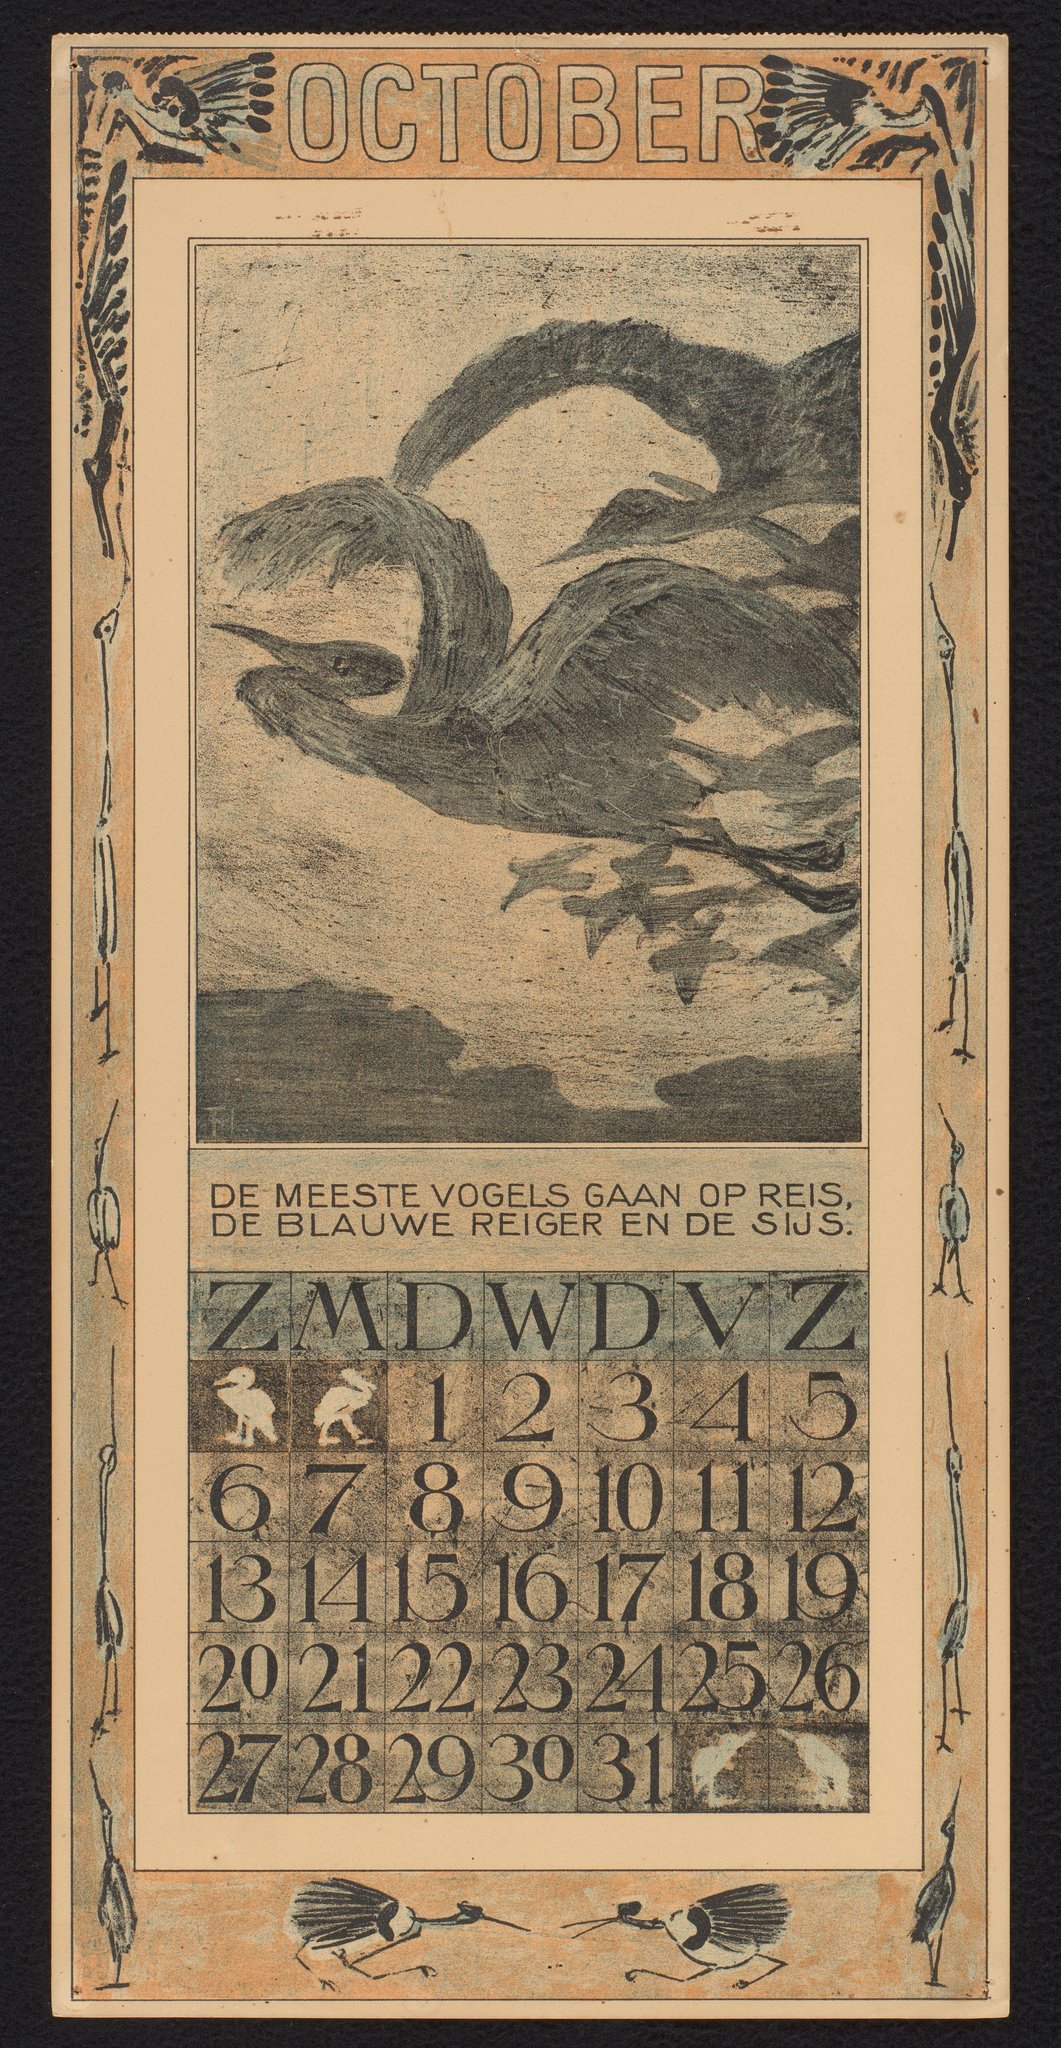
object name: calendar leaf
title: Kalenderblad voor oktober 1907 met reigers op trek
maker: theo van hoytema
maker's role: draughtsman, painter, print maker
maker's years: 1863-1917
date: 1906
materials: paper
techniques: lithograph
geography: amsterdam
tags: calendar, almanac, shore-birds and wading-birds: heron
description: Voorstelling van vogeltrek met reigers en kleinere vogels: 'De meeste vogels gaan op reis, de blauwe reiger en de sijs'.